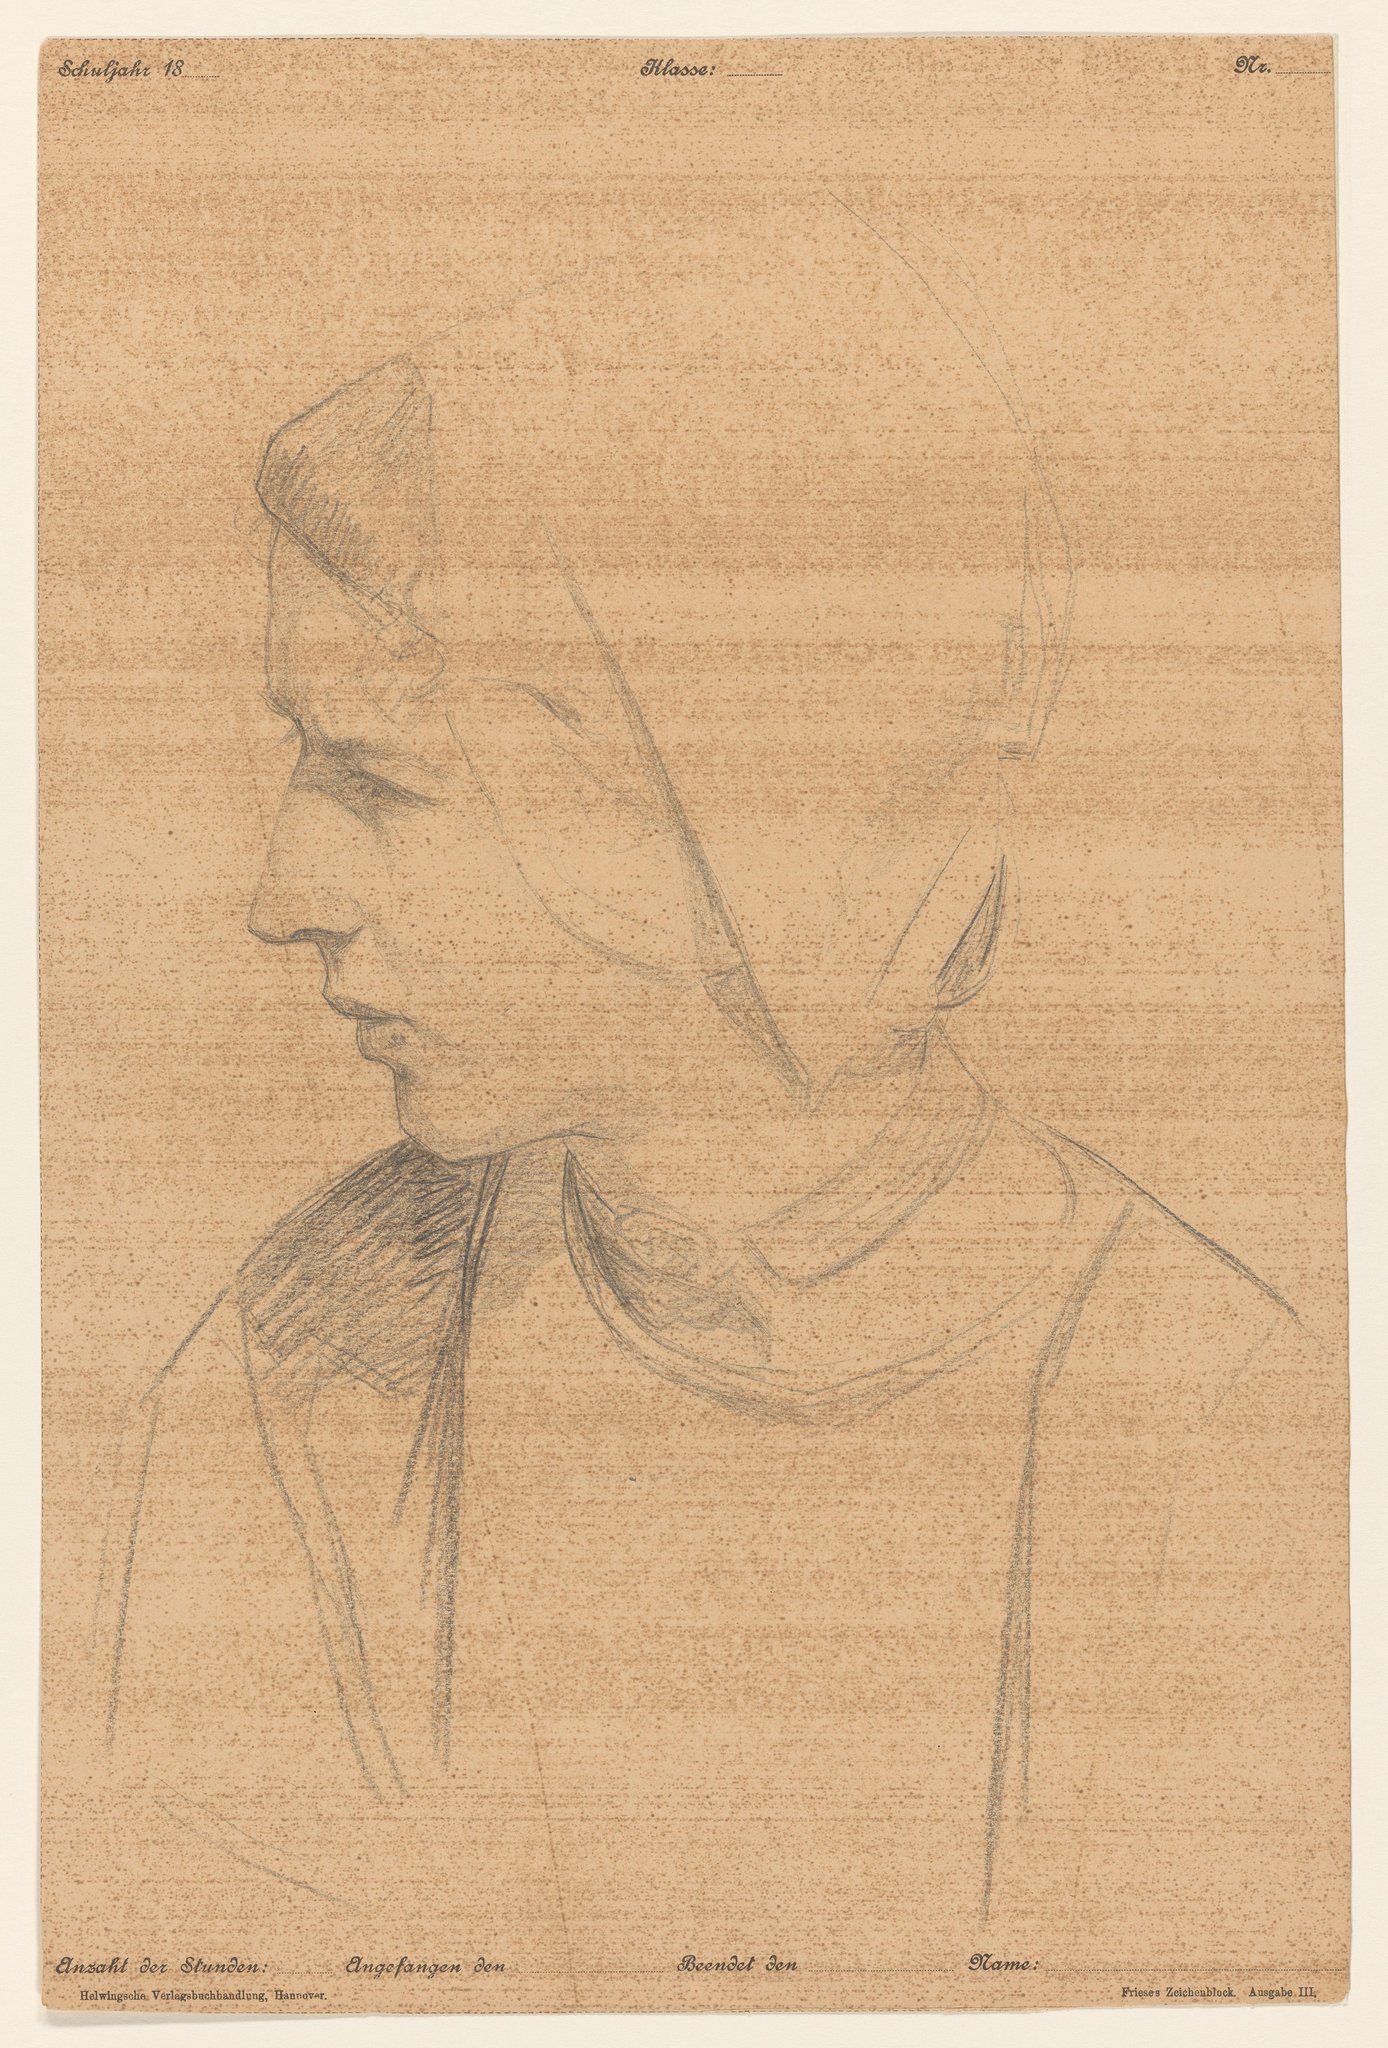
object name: drawing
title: Walcherse boerin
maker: ferdinand hart nibbrig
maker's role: draughtsman, painter, print maker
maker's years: 1866-1915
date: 1876-1915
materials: paper, pencil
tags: folk costume, regional costume